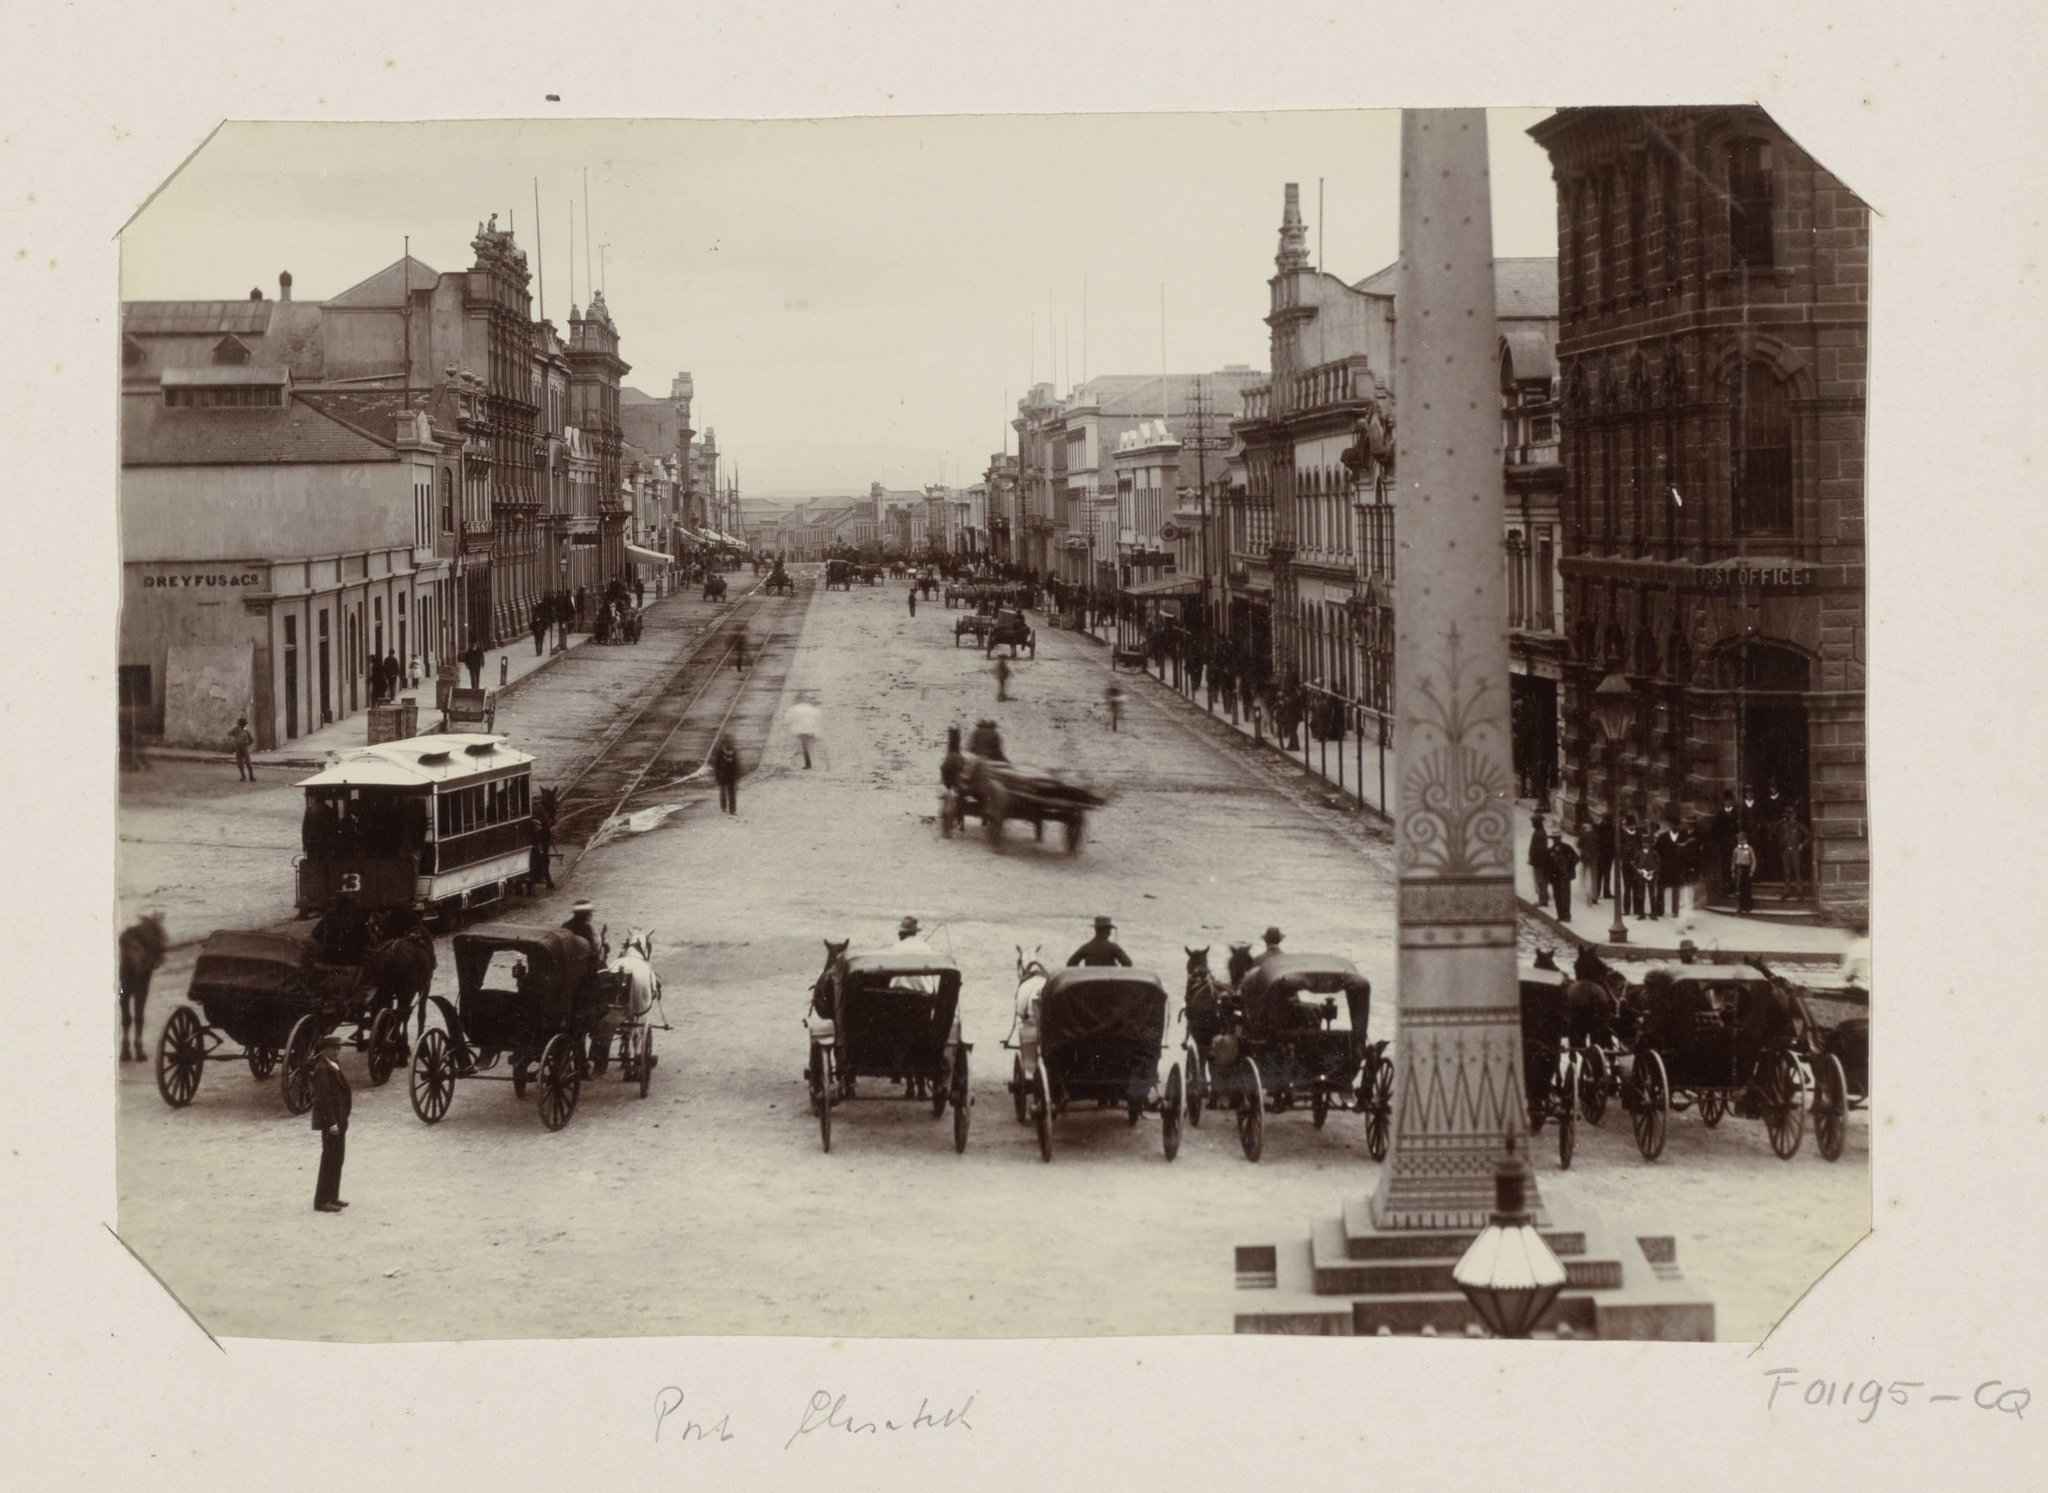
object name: photograph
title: Mainstreet in Port Elizabeth met op de voorgrond wachtende koetsiers bij een obelisk op Market Square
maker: Anonymous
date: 1880-1910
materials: cardboard, paper, photographic support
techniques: gelatin silver print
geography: port elizabeth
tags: animal traction, animal-drawn vehicle (carriage etc.), obelisk, needle, street (+ city(-scape) with figures, staffage)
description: Onderdeel van Fotoalbum van een reis door de Verenigde Staten, Honolulu, Nederlands-Indië, Aden, Zanzibar en Zuidelijk Afrika.